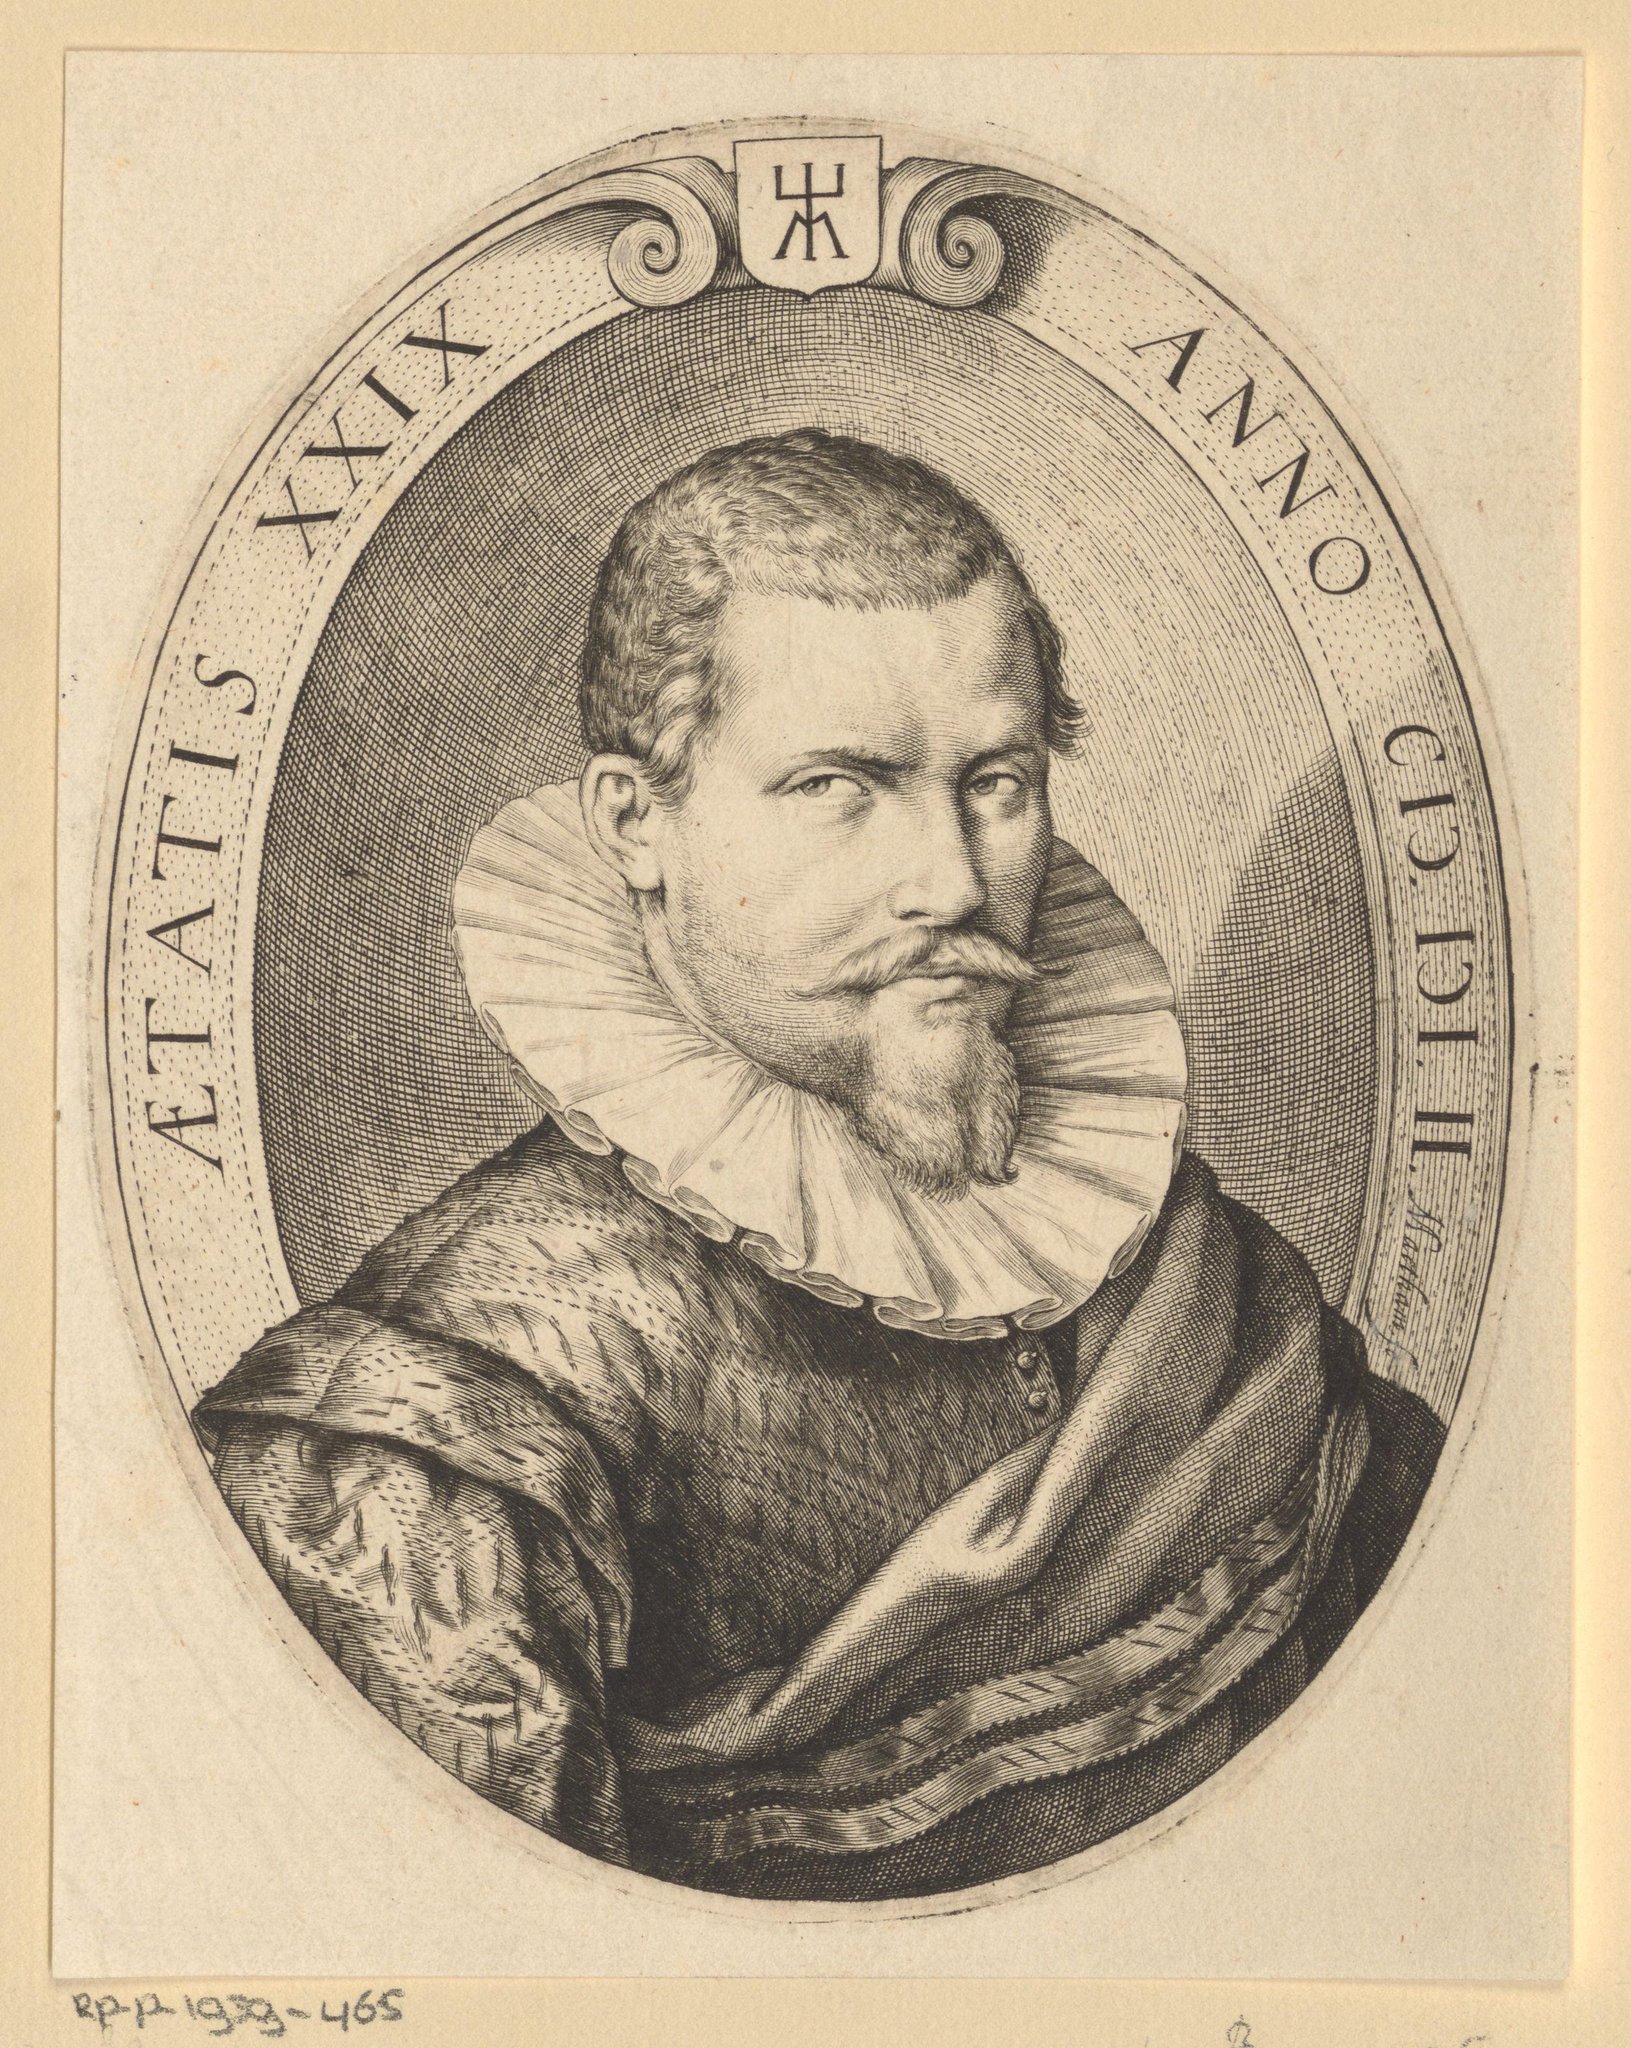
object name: print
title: Portret van een onbekende man op 29-jarige leeftijd, mogelijk Johan Sems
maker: jacob matham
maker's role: draughtsman, print maker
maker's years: 1571-1631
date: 1602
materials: paper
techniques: engraving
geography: haarlem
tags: johan sems, land registry, historical persons, mathematics (+ portrait of scholar, scientist)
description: Volgens Weigel zelfportret en volgens van Someren (5099) Johan Sems (1572-voor 1656), landmeter en mathematicus in Groningen.